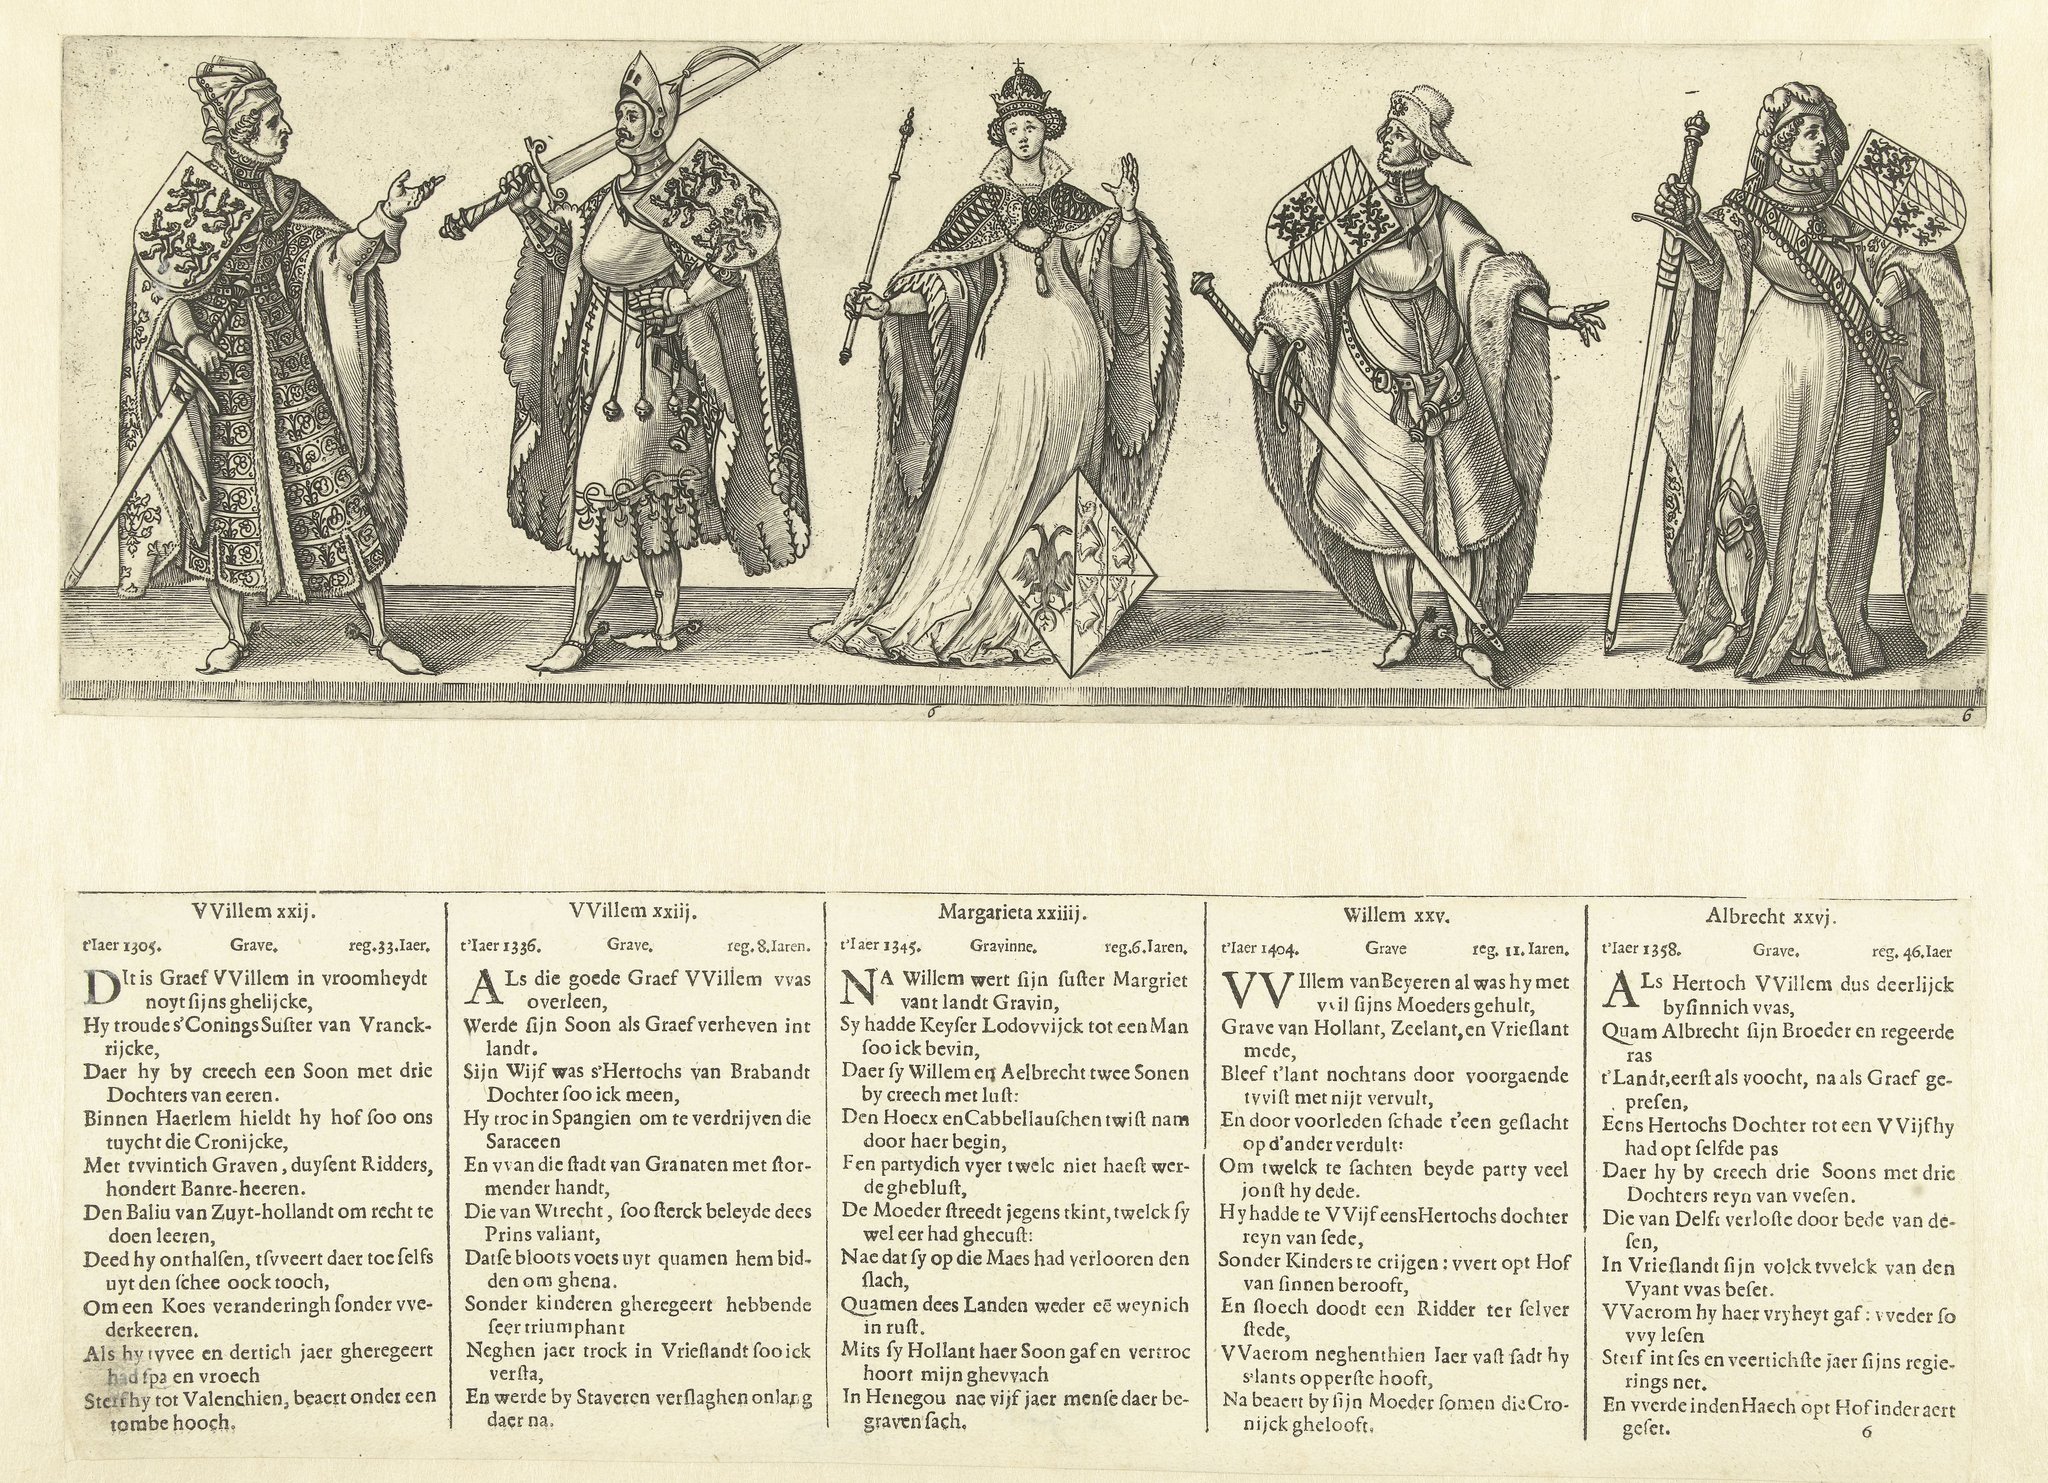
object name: print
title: Graven en gravinnen van Holland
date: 1584-1585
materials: paper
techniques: engraving, letterpress printing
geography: haarlem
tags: willem iii de goede (graaf van holland en henegouwen), earl, willem v van holland (graaf van holland en zeeland), duke of bavaria albert i, willem iv (graaf van holland)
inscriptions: collector's mark: Lugt 2228a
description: Voorstelling van één vrouw met schild en staf, en vier mannen met zwaard en schild. Het gaat volgens het bijbehorende onderschrift om graven van Holland Willem XXII en Willem XXIII, gravin van Holland Margaretha XXIV en graven van Holland Willem XXV en Albrecht XXVI (bedoeld zijn Willem III de Goede, Willem IV, Margaretha van Beieren, Willem V en Albrecht van Beieren). Deze prent is onderdeel van een serie van acht genummerde prenten van de graven en gravinnen van Holland met bijbehorende verklarende Nederlandse teksten in boekdruk. Prent en tekst zijn steeds op één blad bevestigd. Overigens lijkt er van de jaartallen die in de onderschriften vermeld staan weinig te kloppen.